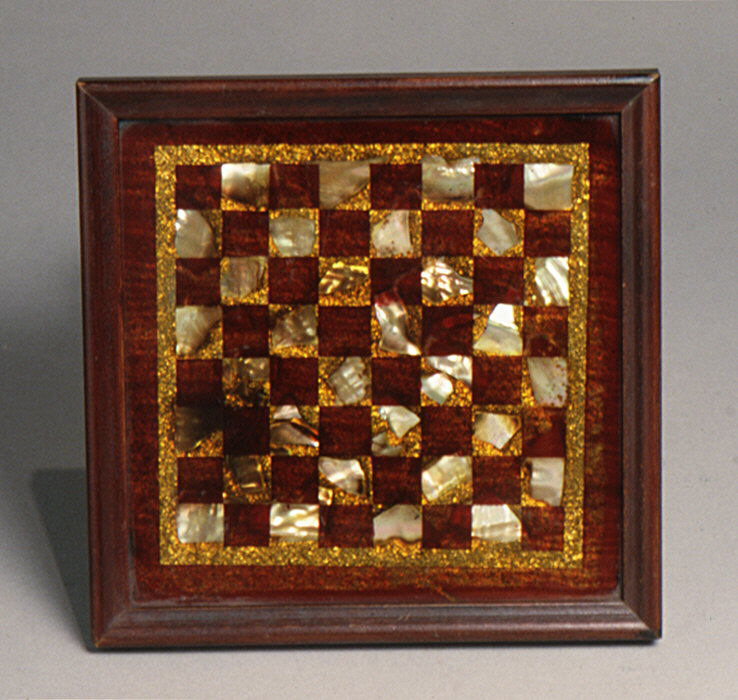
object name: chessboard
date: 1801-1900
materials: celluloid, mother of pearl, wood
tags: chess,games